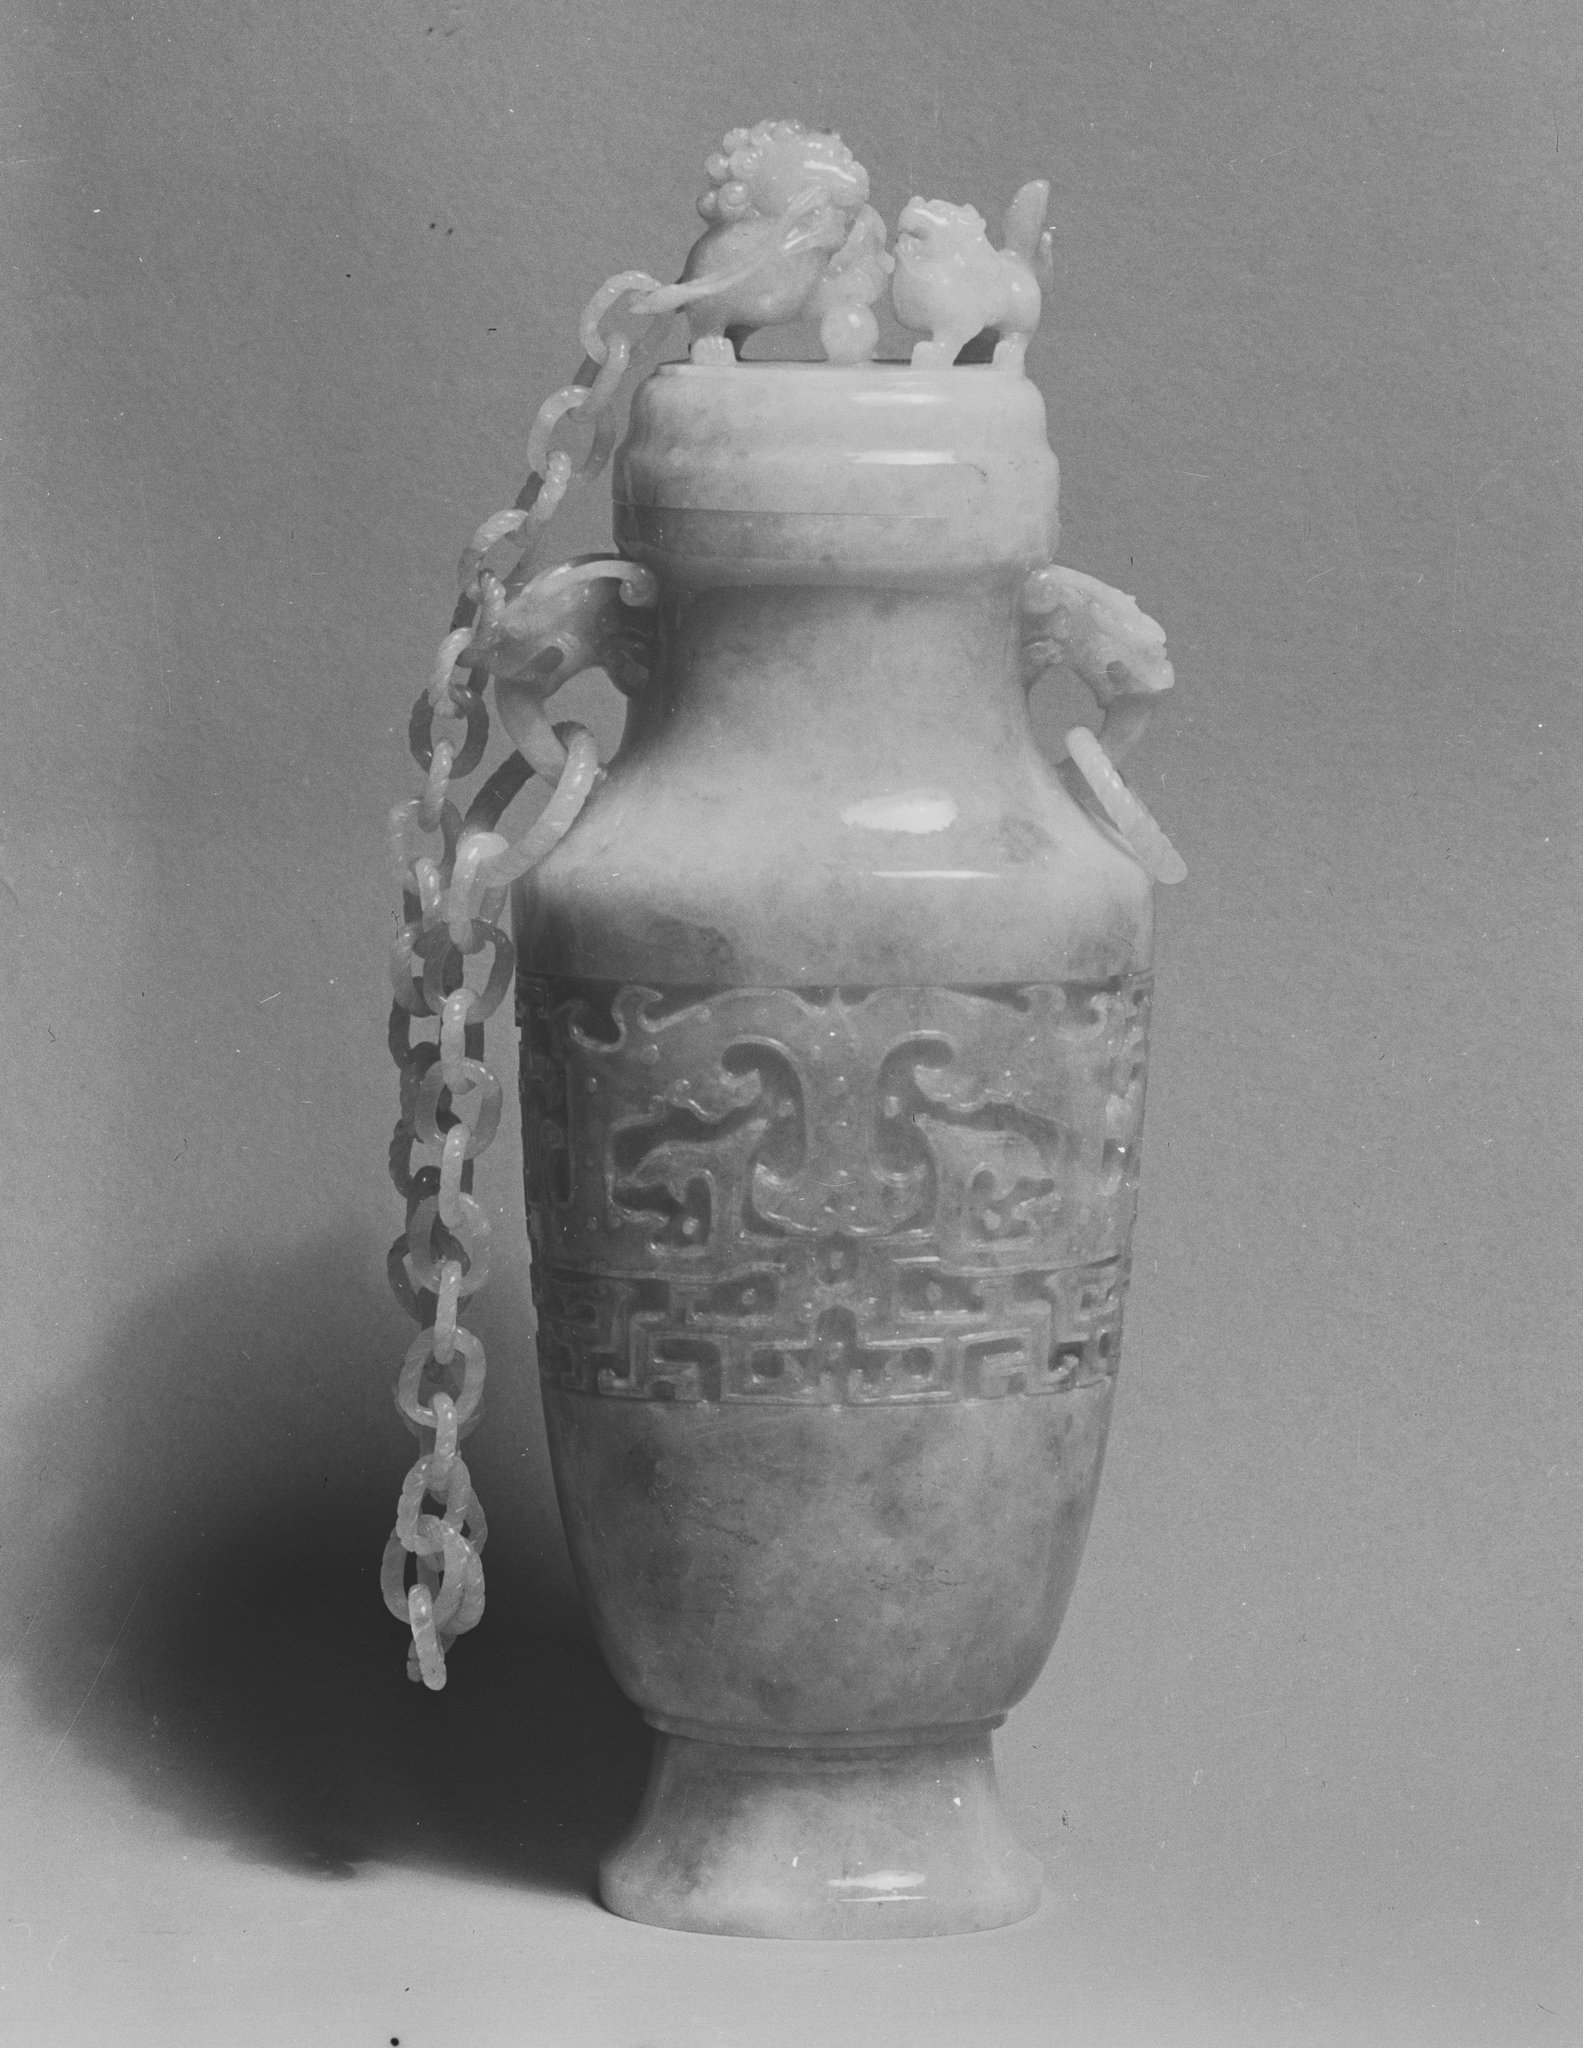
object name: covered vase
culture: chinese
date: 1701-1800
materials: jade